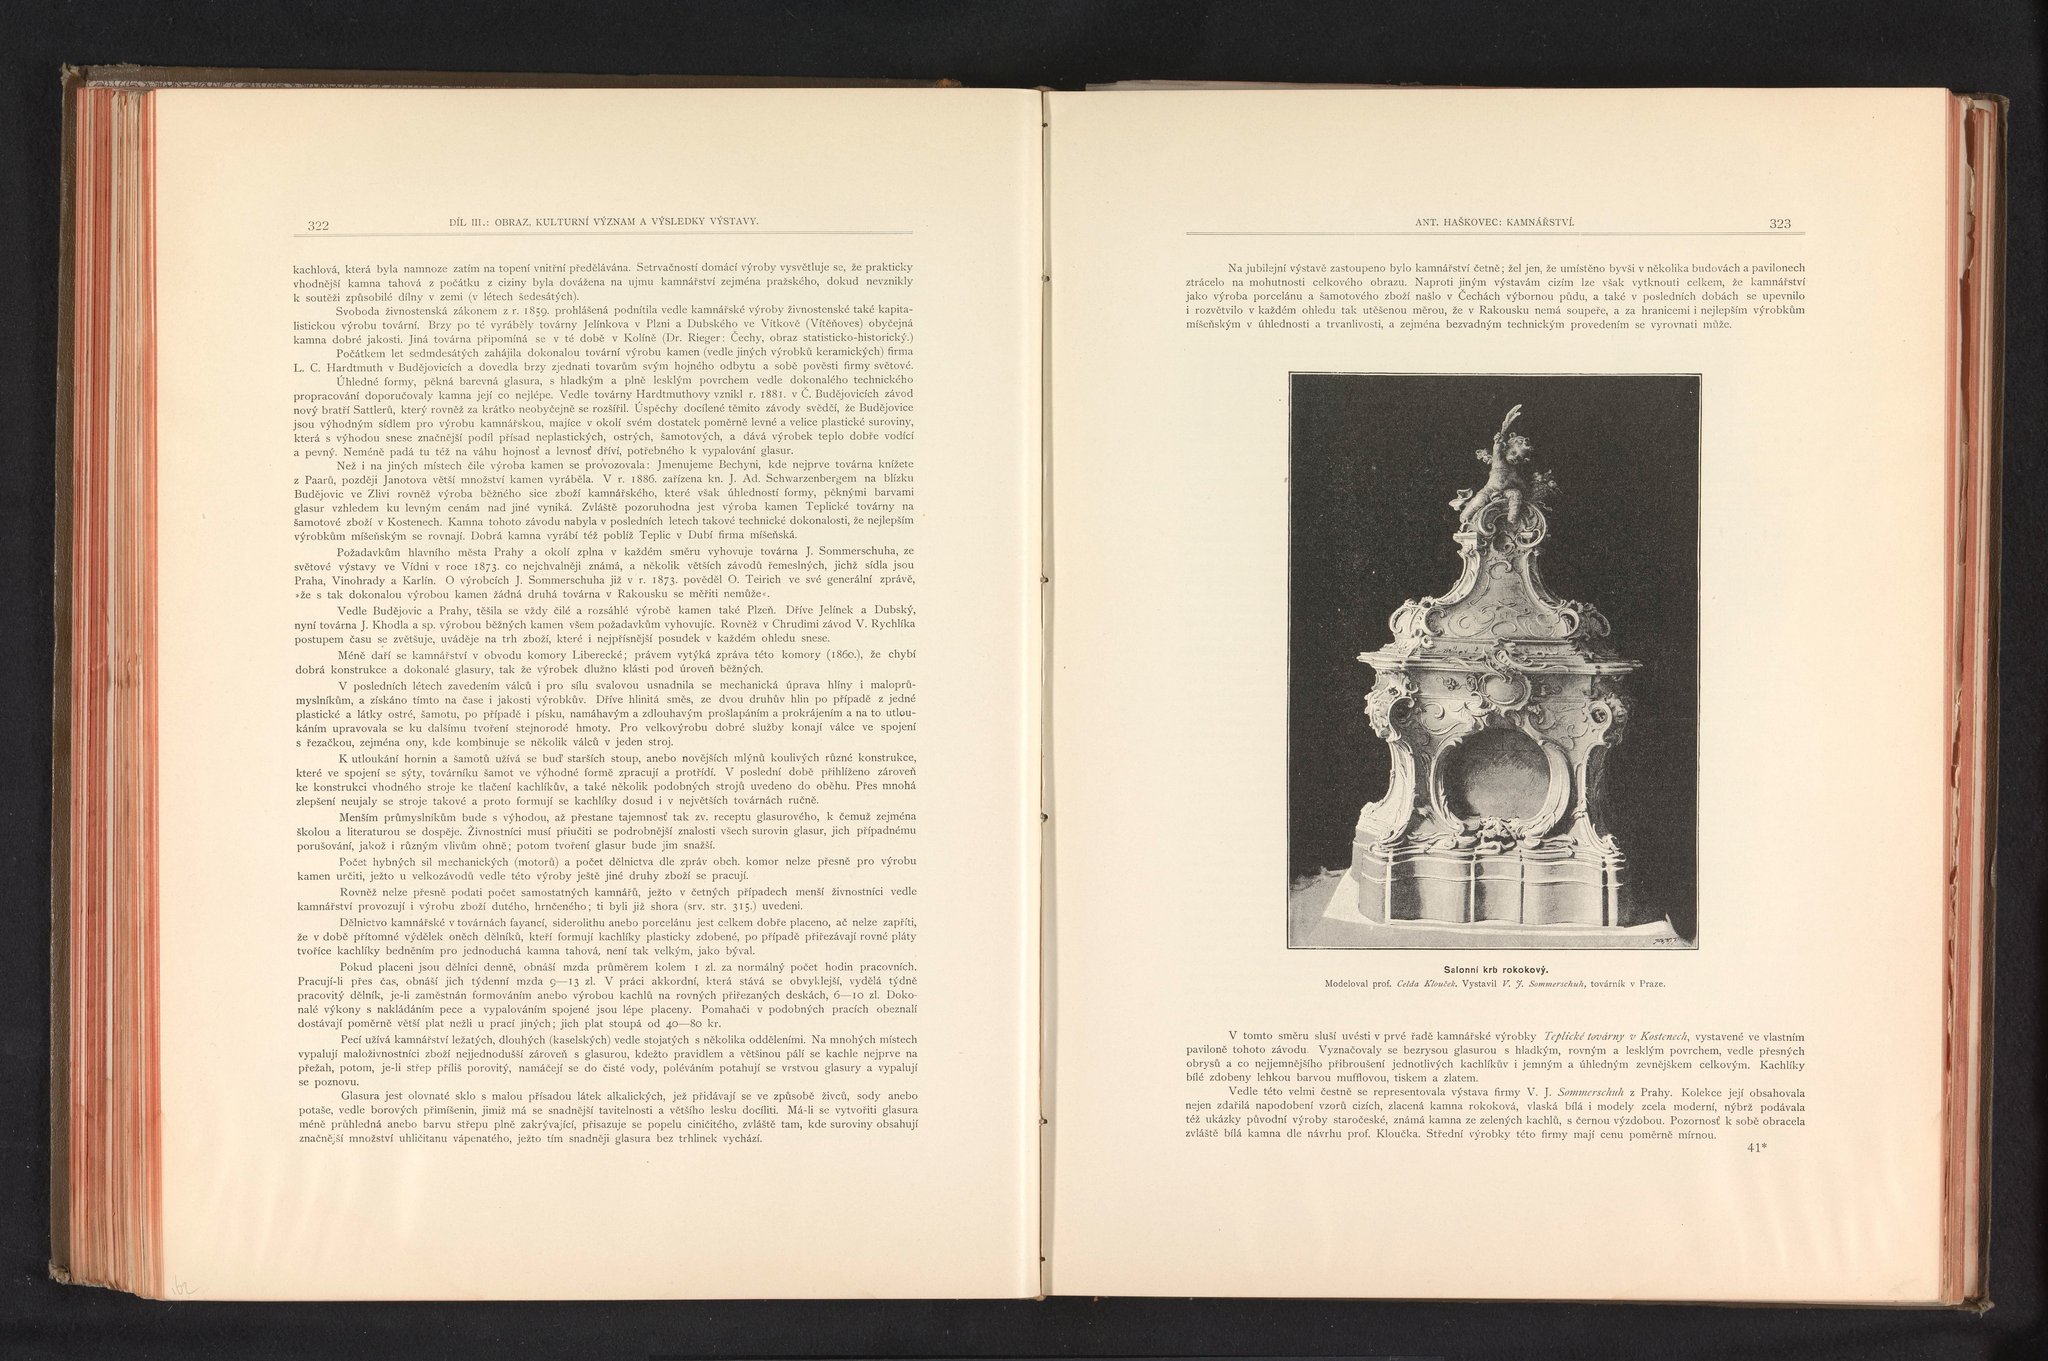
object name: photomechanical print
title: Open haard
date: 1890-1895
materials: paper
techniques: autotype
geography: prague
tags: open hearth, fire-place